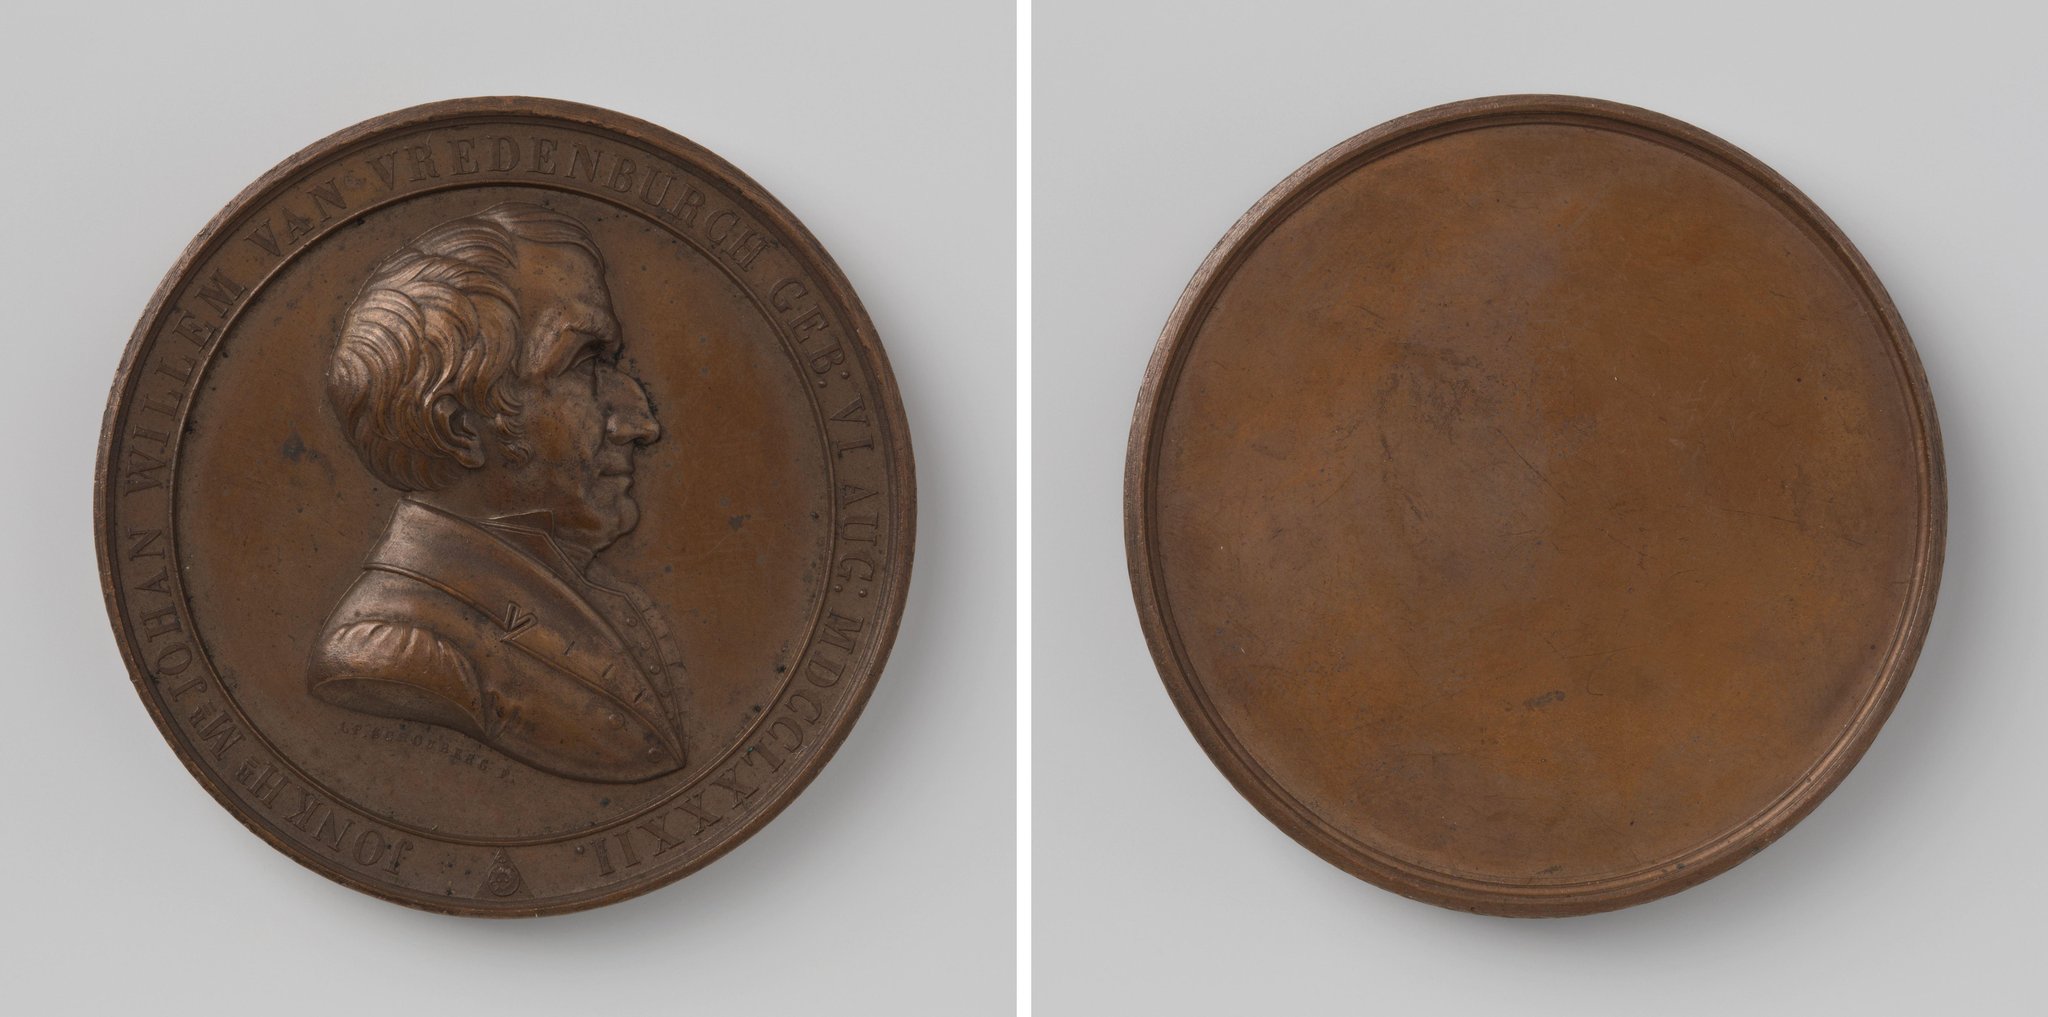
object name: history medal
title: Jonkheer Johan Willem van Vredenburch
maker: johannis petrus schouberg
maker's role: die cutter, draughtsman, print maker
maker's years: 1798-1864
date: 1842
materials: bronze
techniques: striking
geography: utrecht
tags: jonkheer johan willem van vredenburch van groeneveld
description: Eenzijdige bronzen penning. Voorzijde: borststuk man binnen omschrift. Keerzijde: blanco